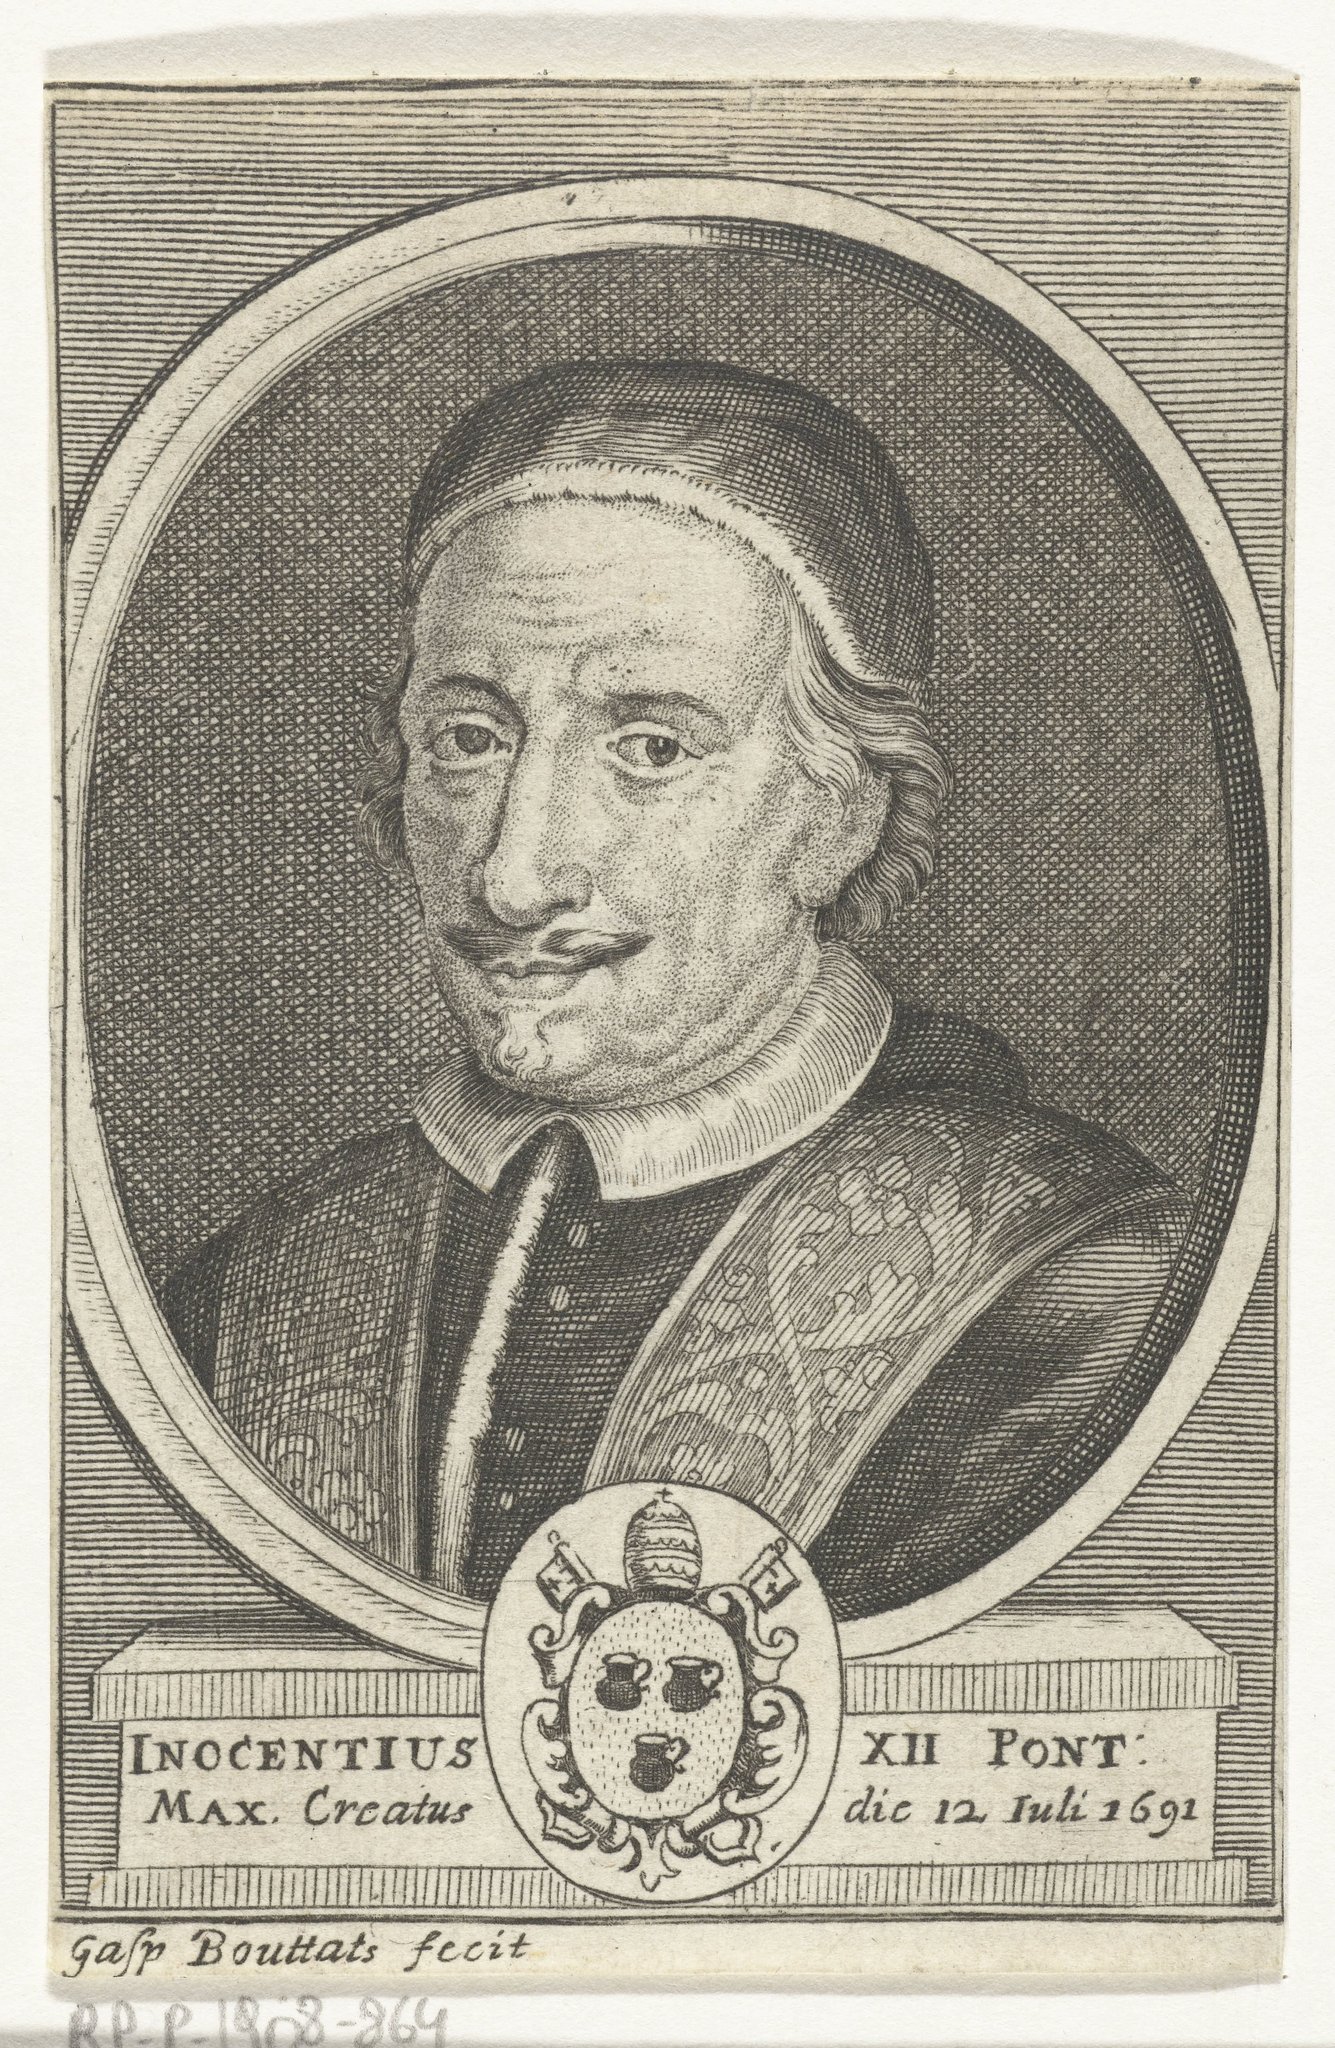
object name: print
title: Portret van Innocentius XII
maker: gaspar bouttats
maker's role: print maker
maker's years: 1640-1695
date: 1691-1695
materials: paper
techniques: engraving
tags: naples, rome, clergyman, innocentius xii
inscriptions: collector's mark: Lugt 2228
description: Portret in een ovale lijst van paus Innocentius XII, Antonio Pignatelli . Buste naar links. Onder het portret het wapenschild van de paus. De prent heeft een Latijns onderschrift met de naam van de geportretteerde.